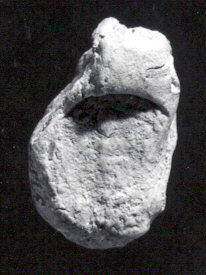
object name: sealing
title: Sealing with one circular seal impression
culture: assyrian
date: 1800-1701 BCE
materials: clay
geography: anatolia